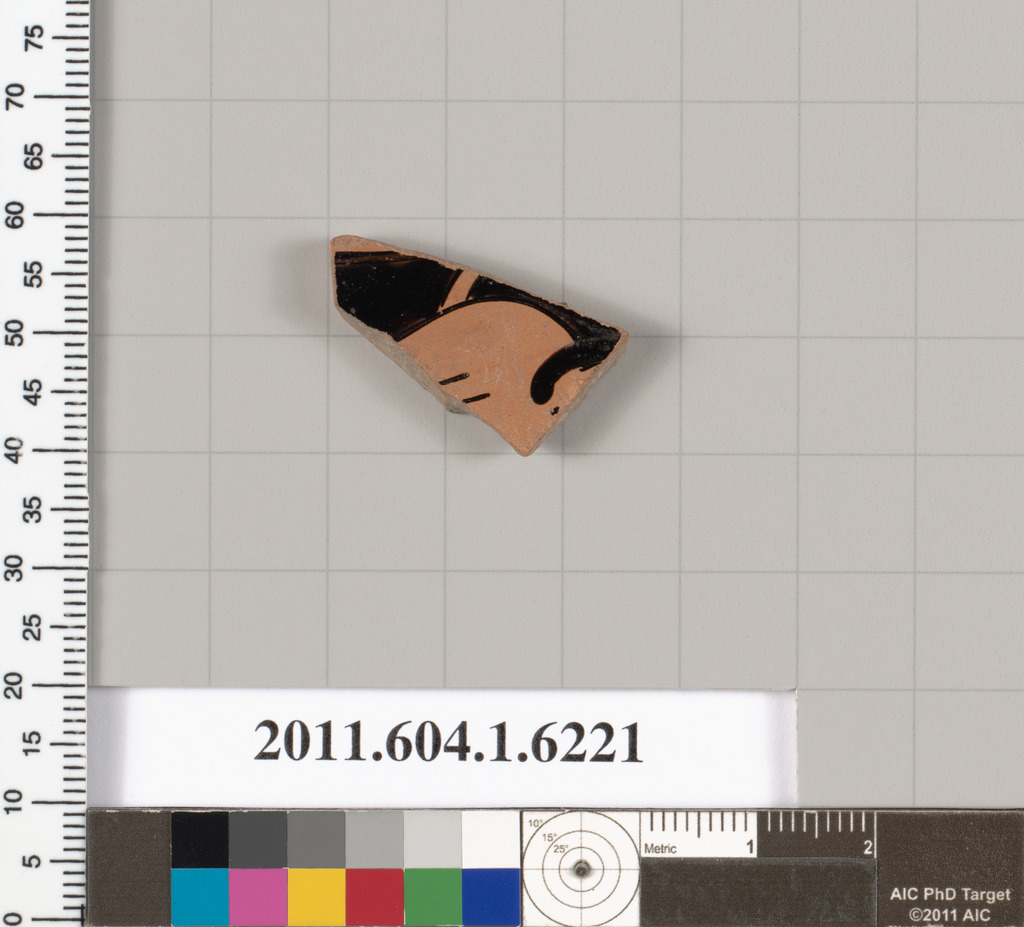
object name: kylix fragment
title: Terracotta fragment of a kylix (drinking cup)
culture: greek, attic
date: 510-500 BCE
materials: terracotta